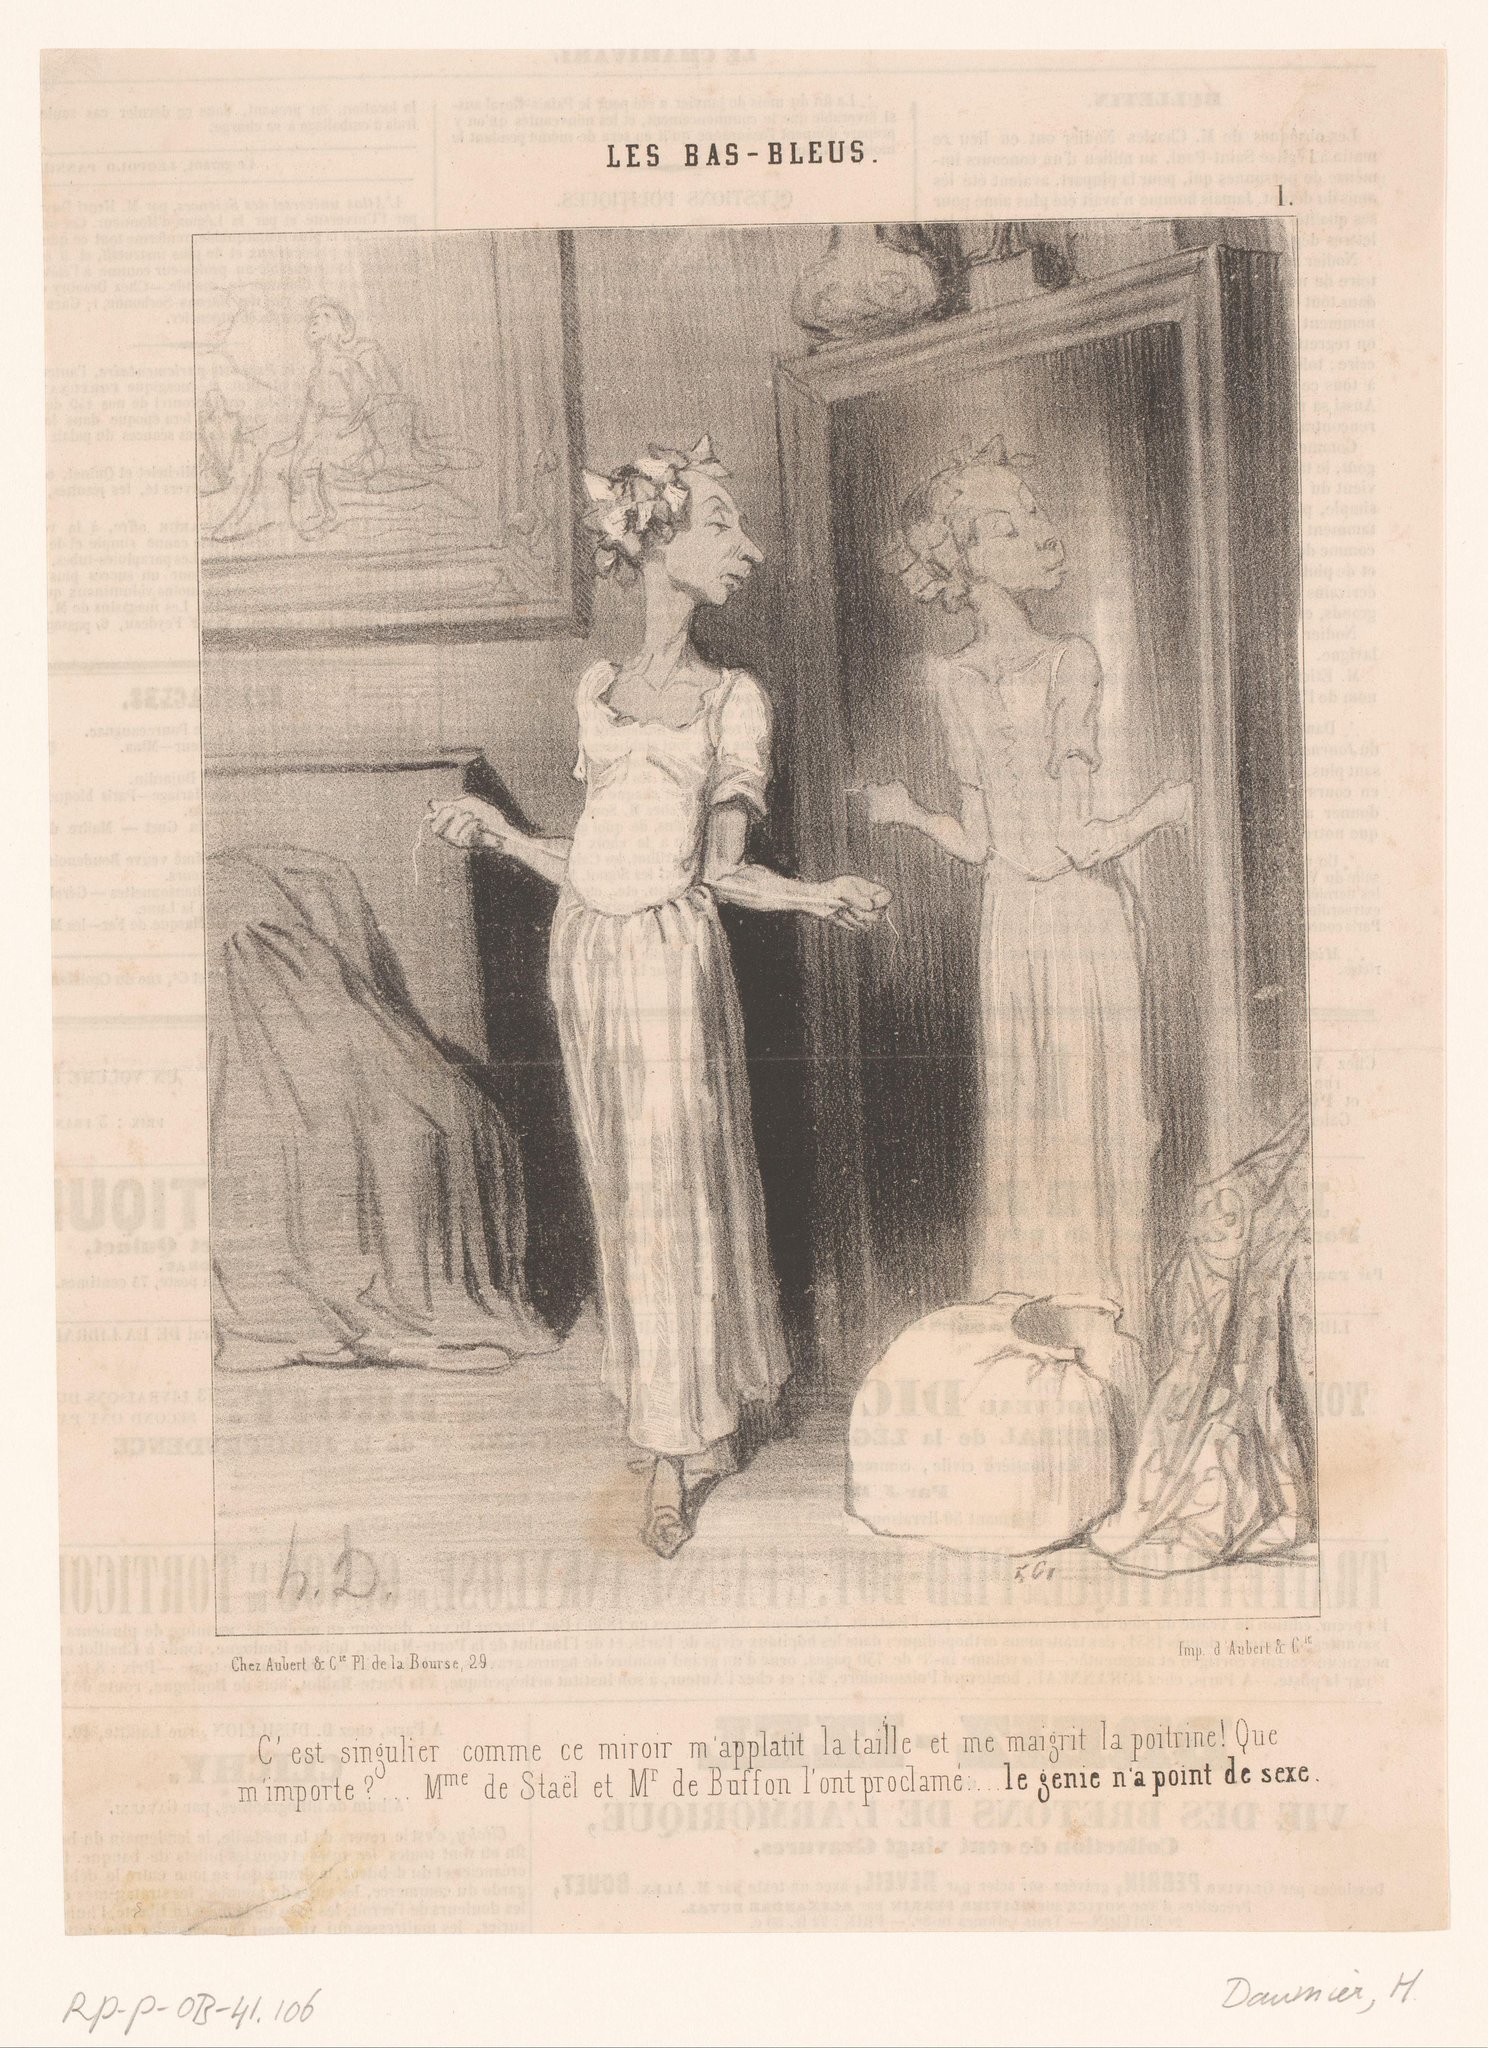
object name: cartoon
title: Pedante vrouwen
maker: honoré daumier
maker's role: draughtsman, painter, print maker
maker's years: 1808-1879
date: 1844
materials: paper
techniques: lithograph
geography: paris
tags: looking in the mirror; (possibly: contemplation of own beauty - aa - (for) women), caricatures (human types), dressing oneself, getting dressed - aa - female human figure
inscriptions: collector's mark: Lugt 2228a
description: De vrouw vindt dat haar figuur niet optimaal uitkomt in de spiegel. Ze relativeert dit echter met de uitspraak dat het genie helemaal geen sekse heeft.